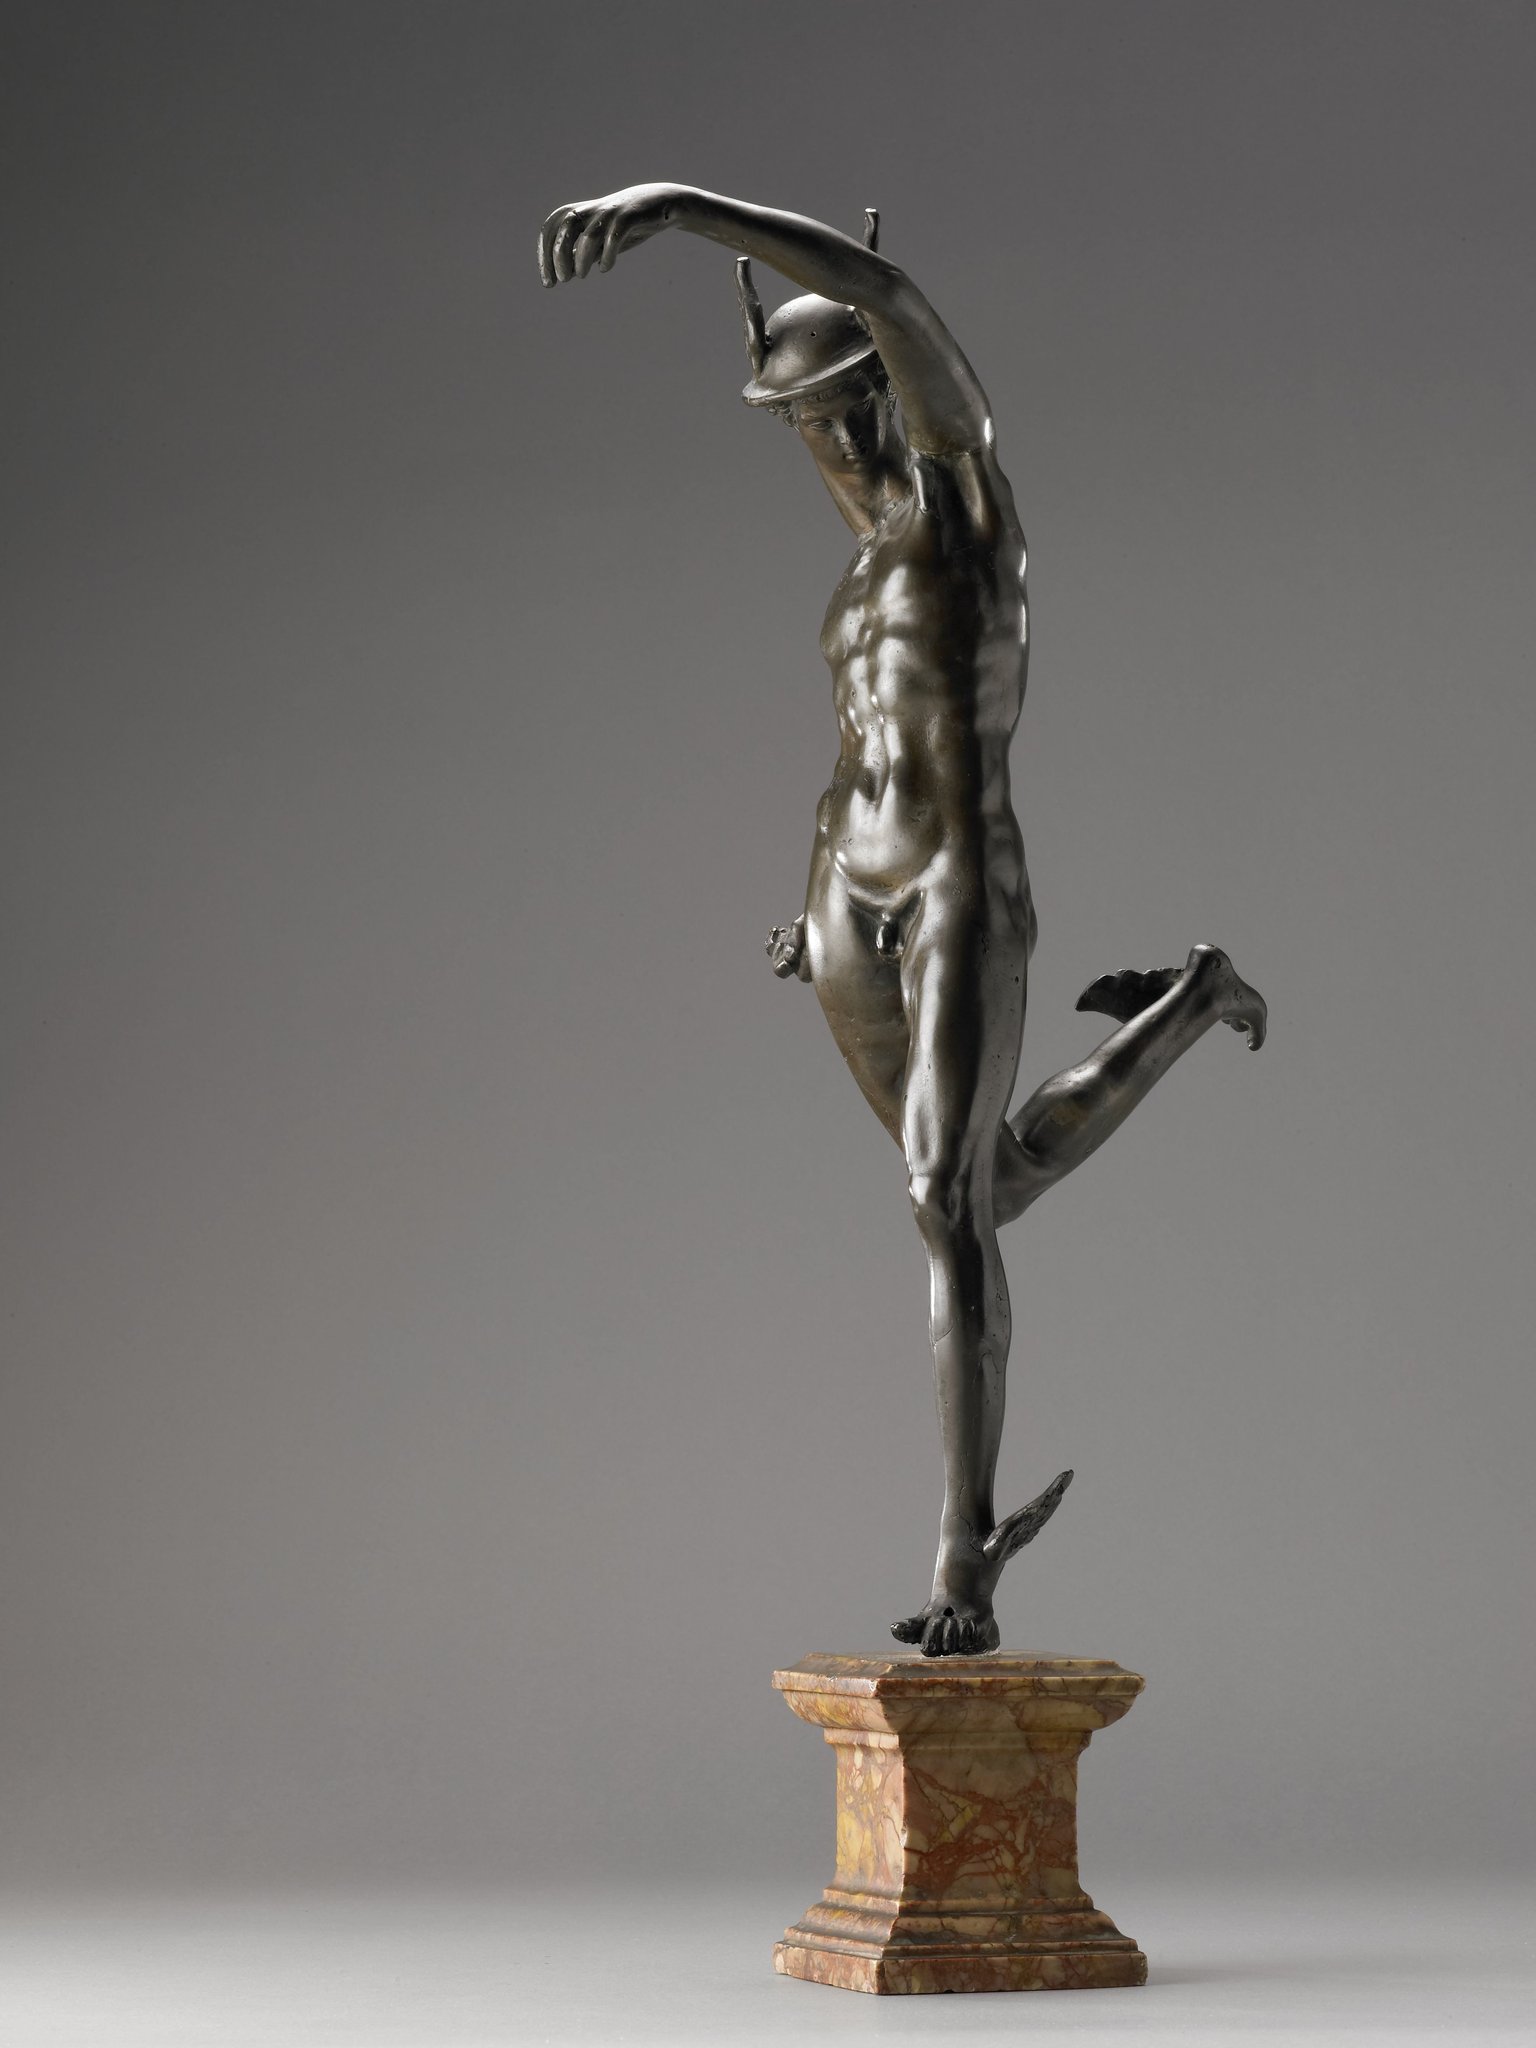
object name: sculpture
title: Mercury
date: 1560-1565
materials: bronze, marble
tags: (story of) mercury (hermes)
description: The winged Mercury is one of the most beloved themes in late 16th- and 17th-century bronze sculpture. As the swift messenger of the classical gods he is invariably shown in full flight, balancing only on the toes of one foot. This gave rise to an elegant composition that, in keeping with the aesthetics of Mannerism, afforded an enchanting profile from all angles.